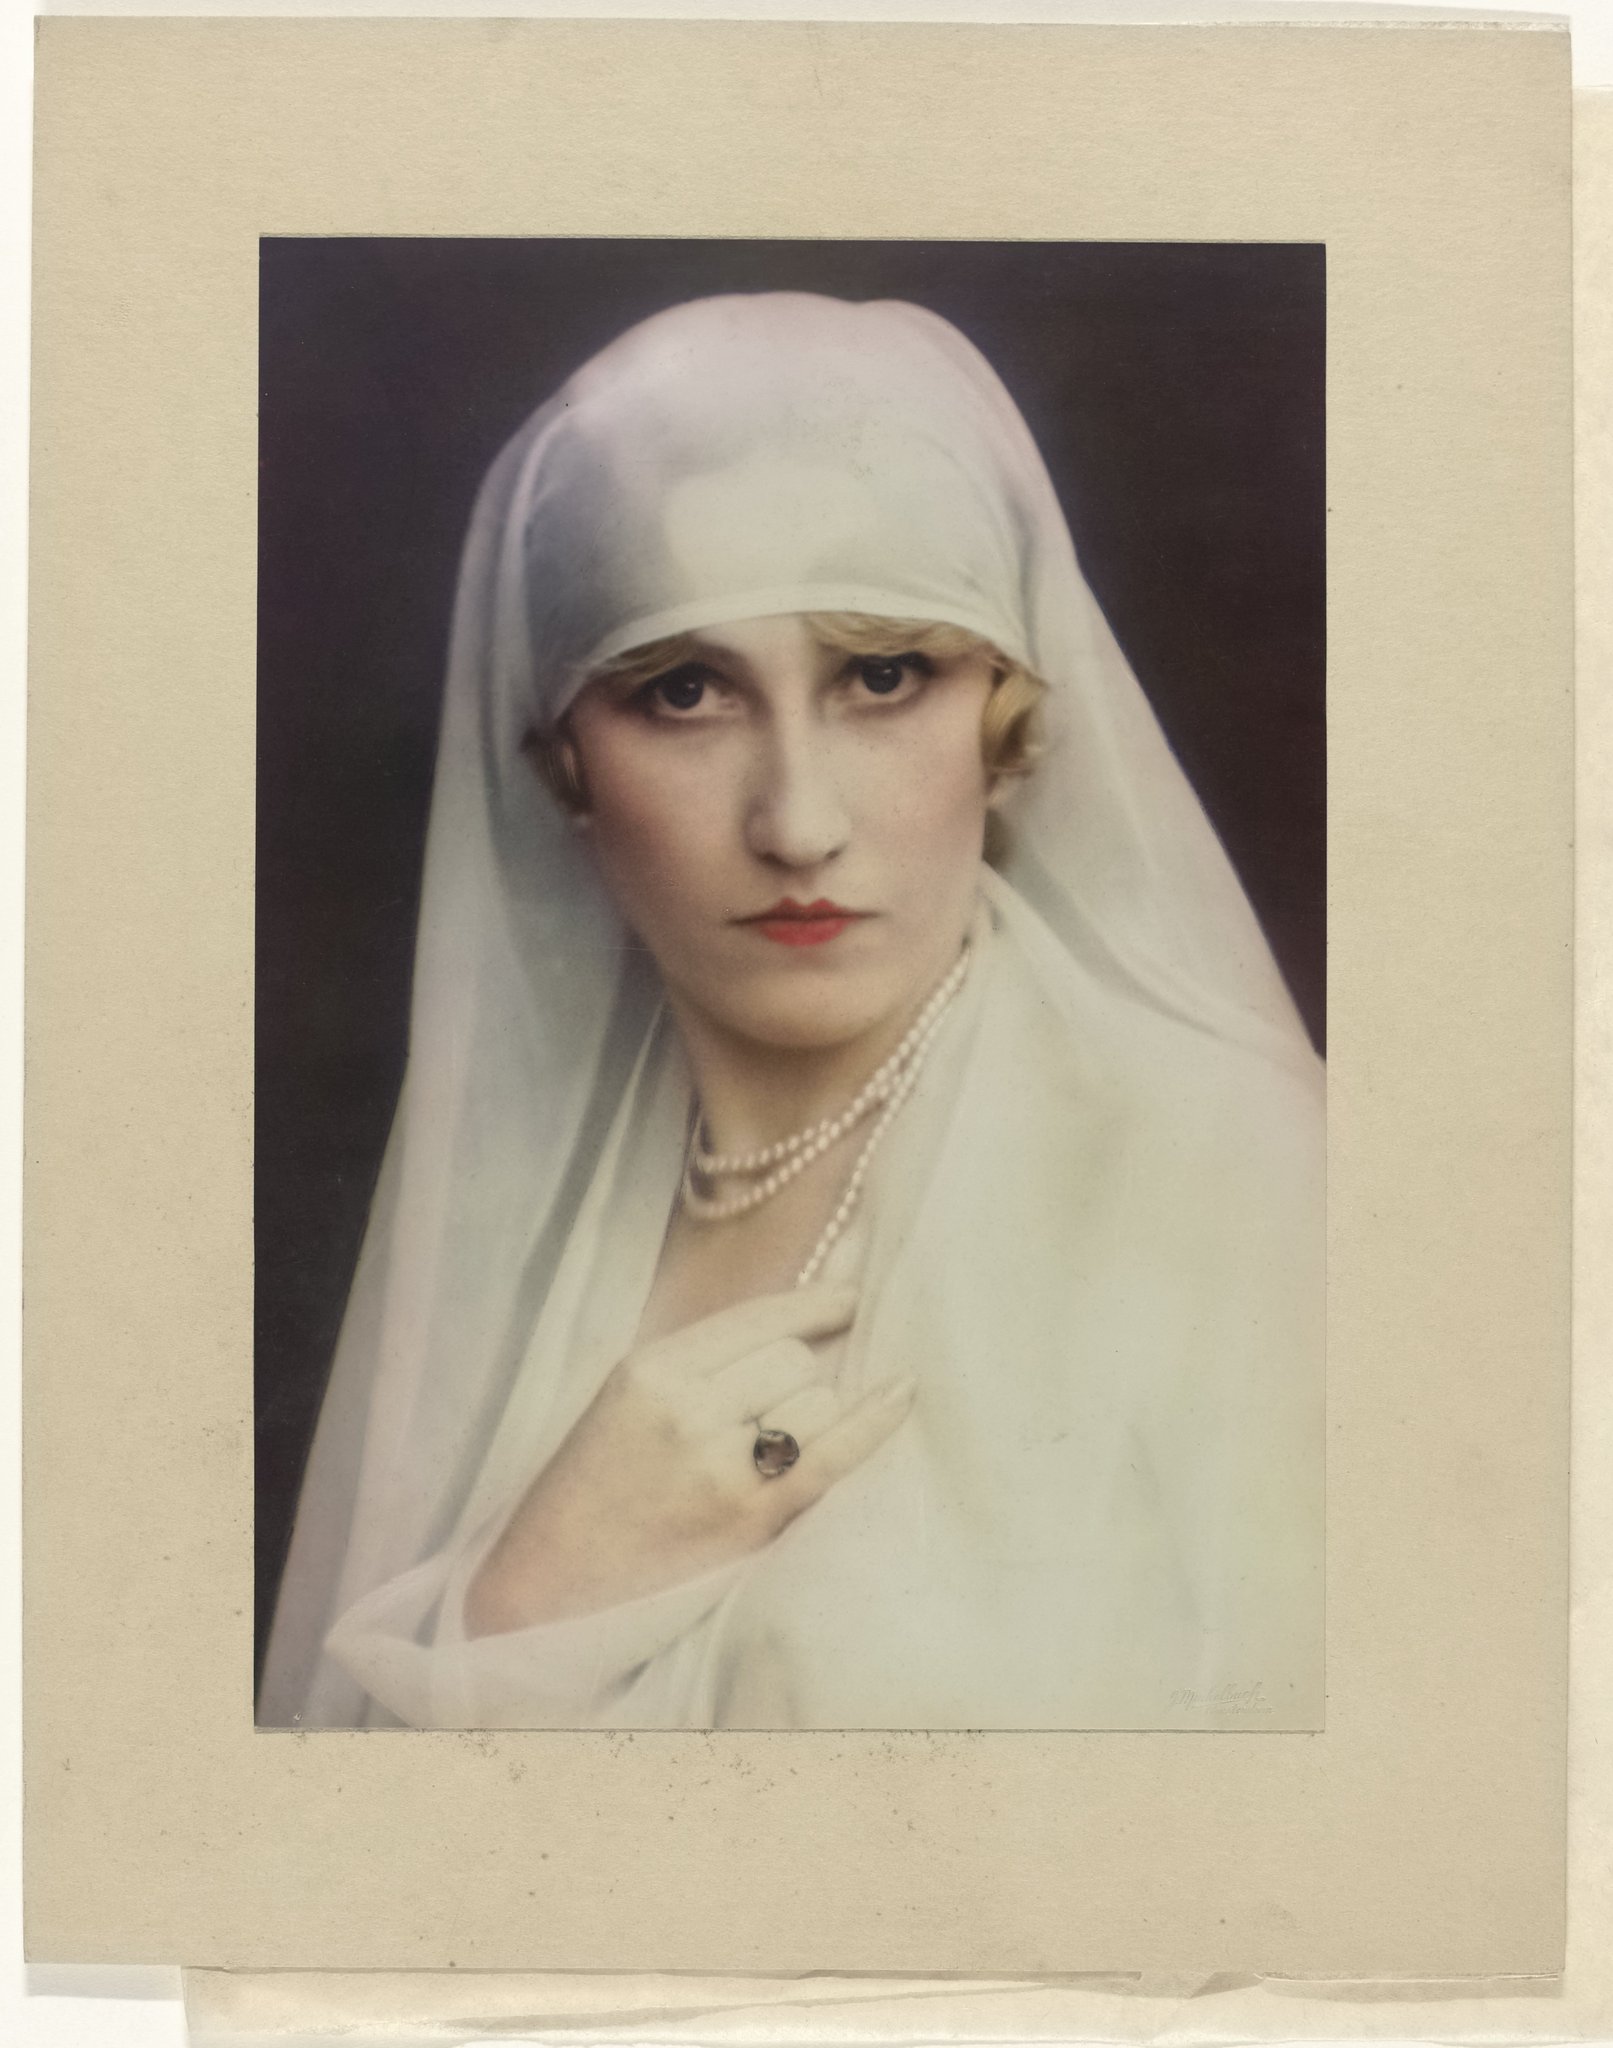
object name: photograph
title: Portret van vrouw met sluier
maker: jacob merkelbach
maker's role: fotograaf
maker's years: 1877-1942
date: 1920-1930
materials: cardboard, photographic support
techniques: jos-pé print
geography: amsterdam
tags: anonymous historical person portrayed - bb - woman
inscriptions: check stamp: ‘J. Merkelbach’